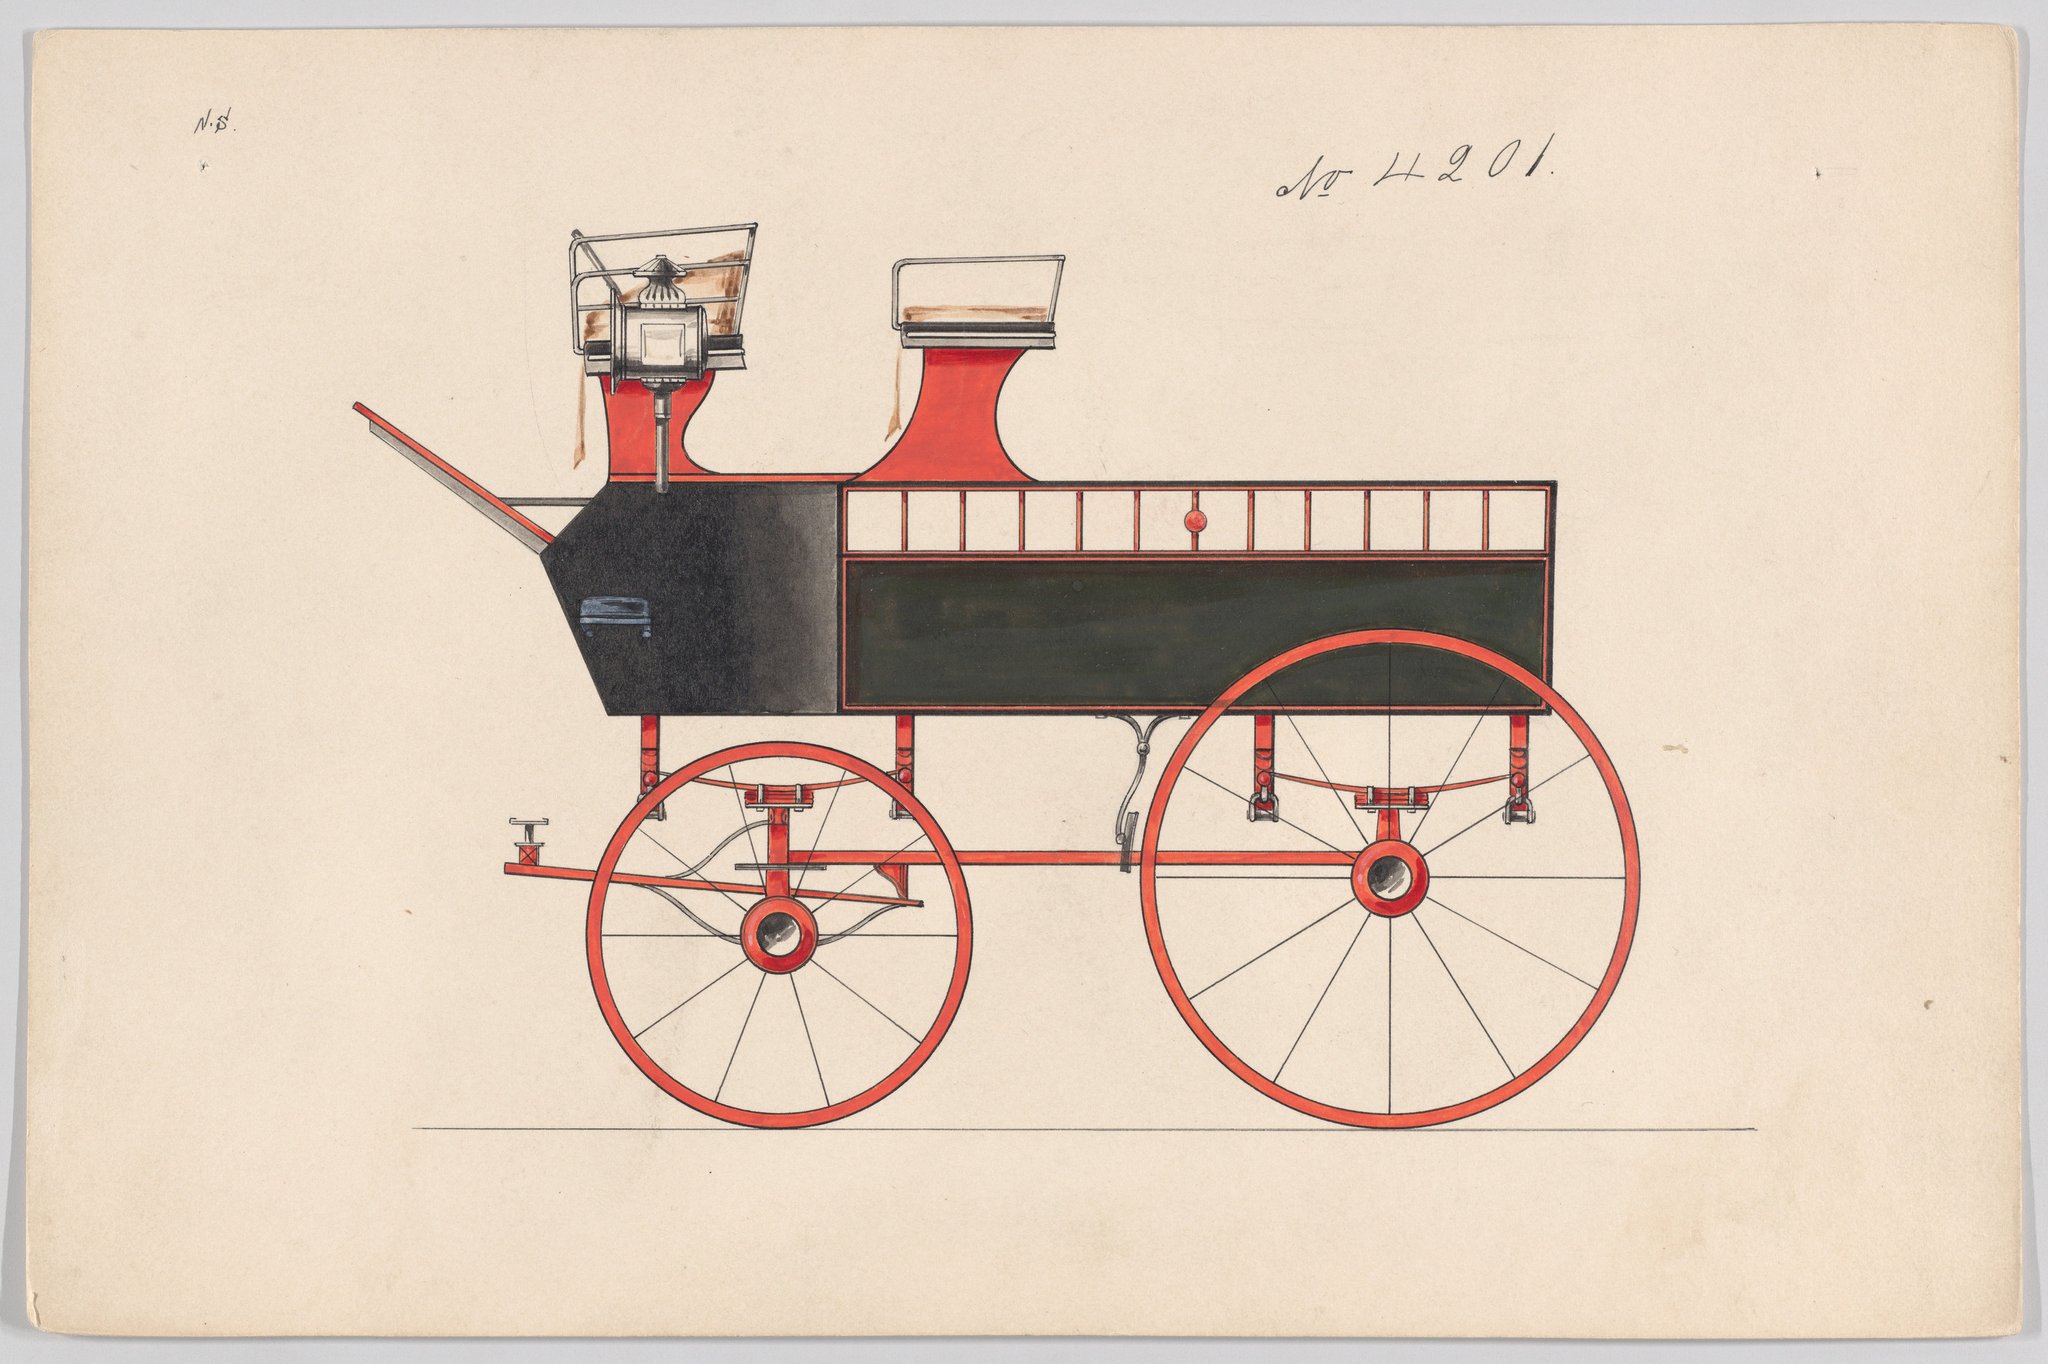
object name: drawing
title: Wagonette Break #4201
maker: brewster & co.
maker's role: manufacturer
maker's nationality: american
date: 1893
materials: gouache, gum arabic, ink, watercolor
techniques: pen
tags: carriages